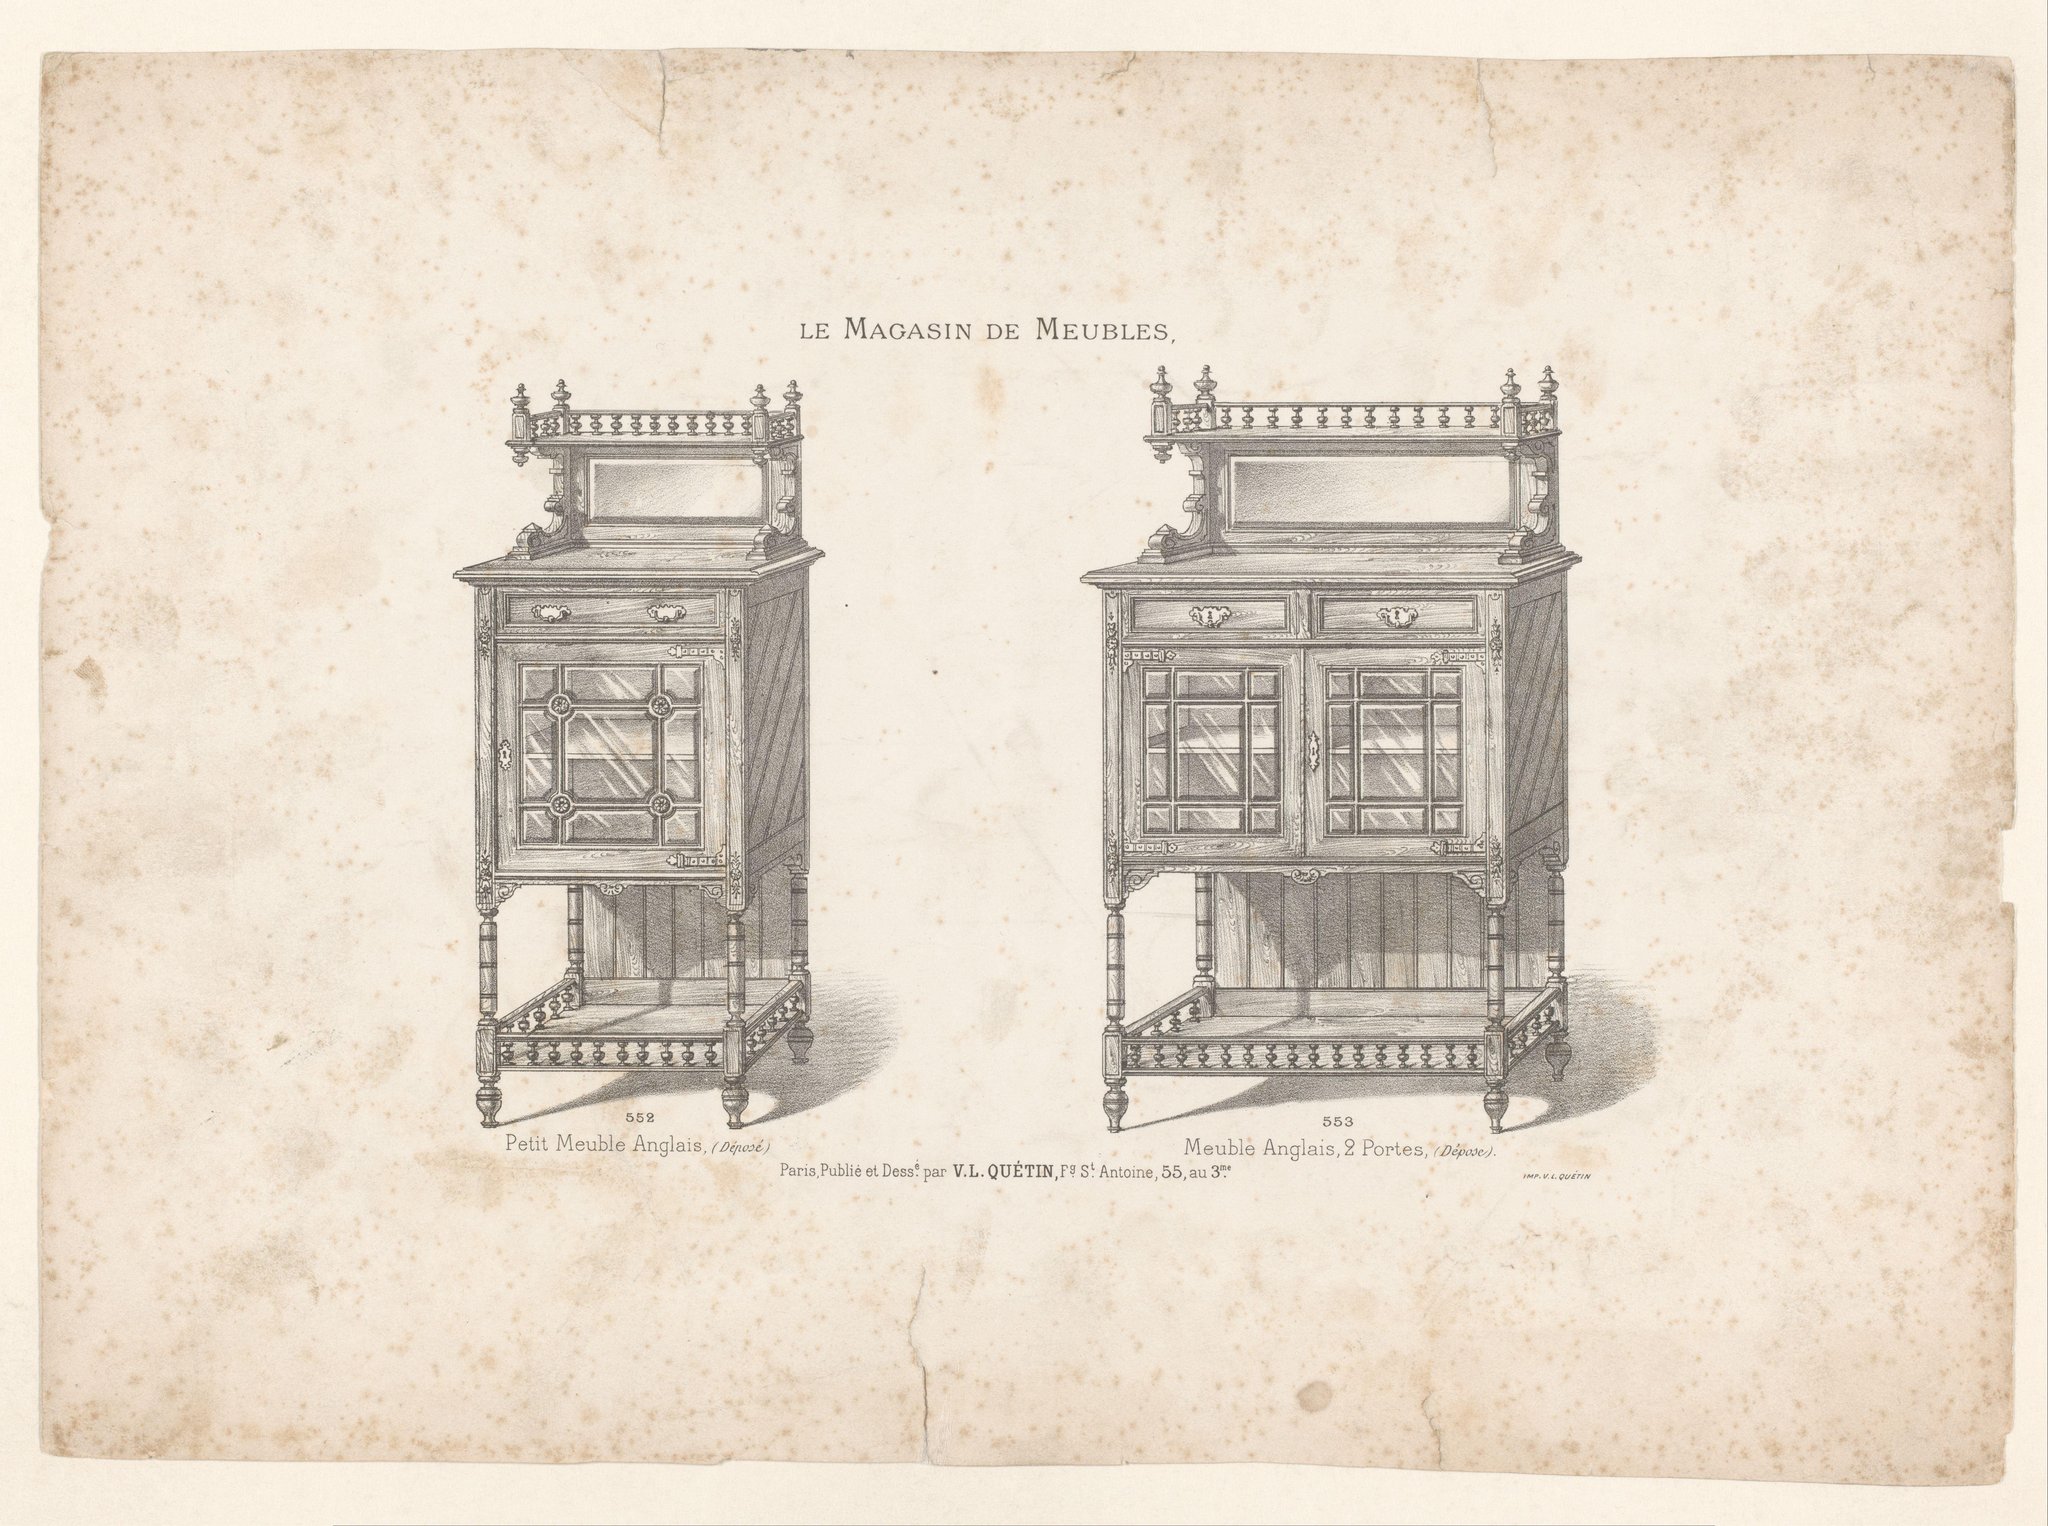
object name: print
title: Le Magasin de Meubles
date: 1878-1904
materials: paper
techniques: lithograph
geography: paris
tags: furniture for storage